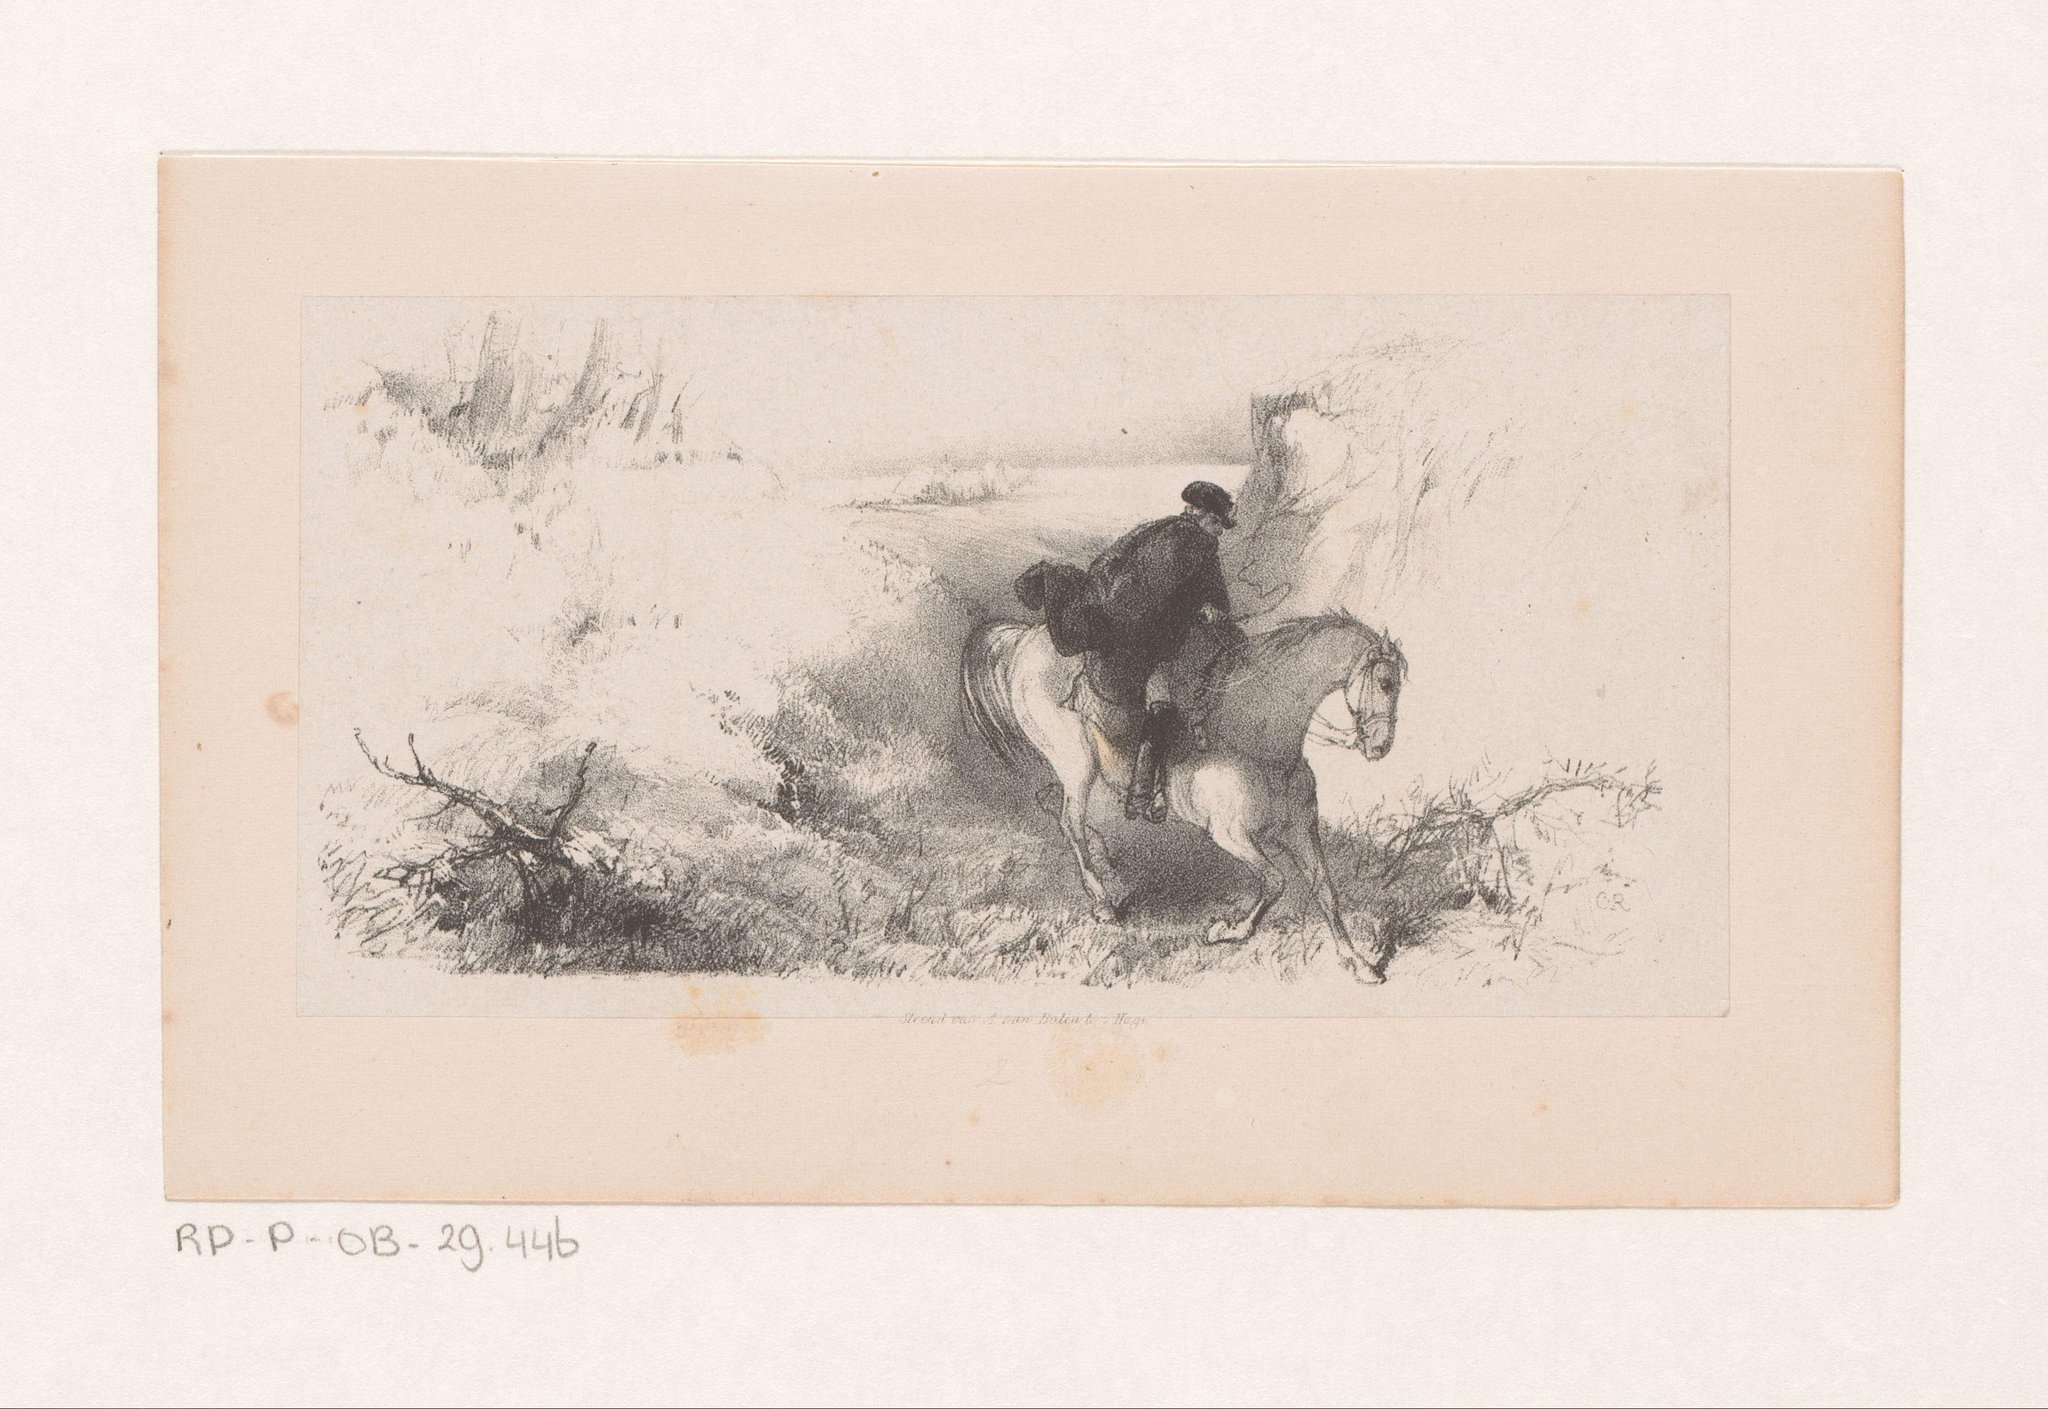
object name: print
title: Baron von Münchhausen te paard in landschap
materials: paper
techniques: lithograph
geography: the hague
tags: riding a horse, ass, or mule; rider, horseman, baron münchausen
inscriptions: collector's mark: Lugt 2228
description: Prent uit: Raspe, Rudolf Erich. Zonderlinge reizen en lotgevallen van den Vrijheer von Münchhausen. Den Haag: Bisschop, J.H., 1843.